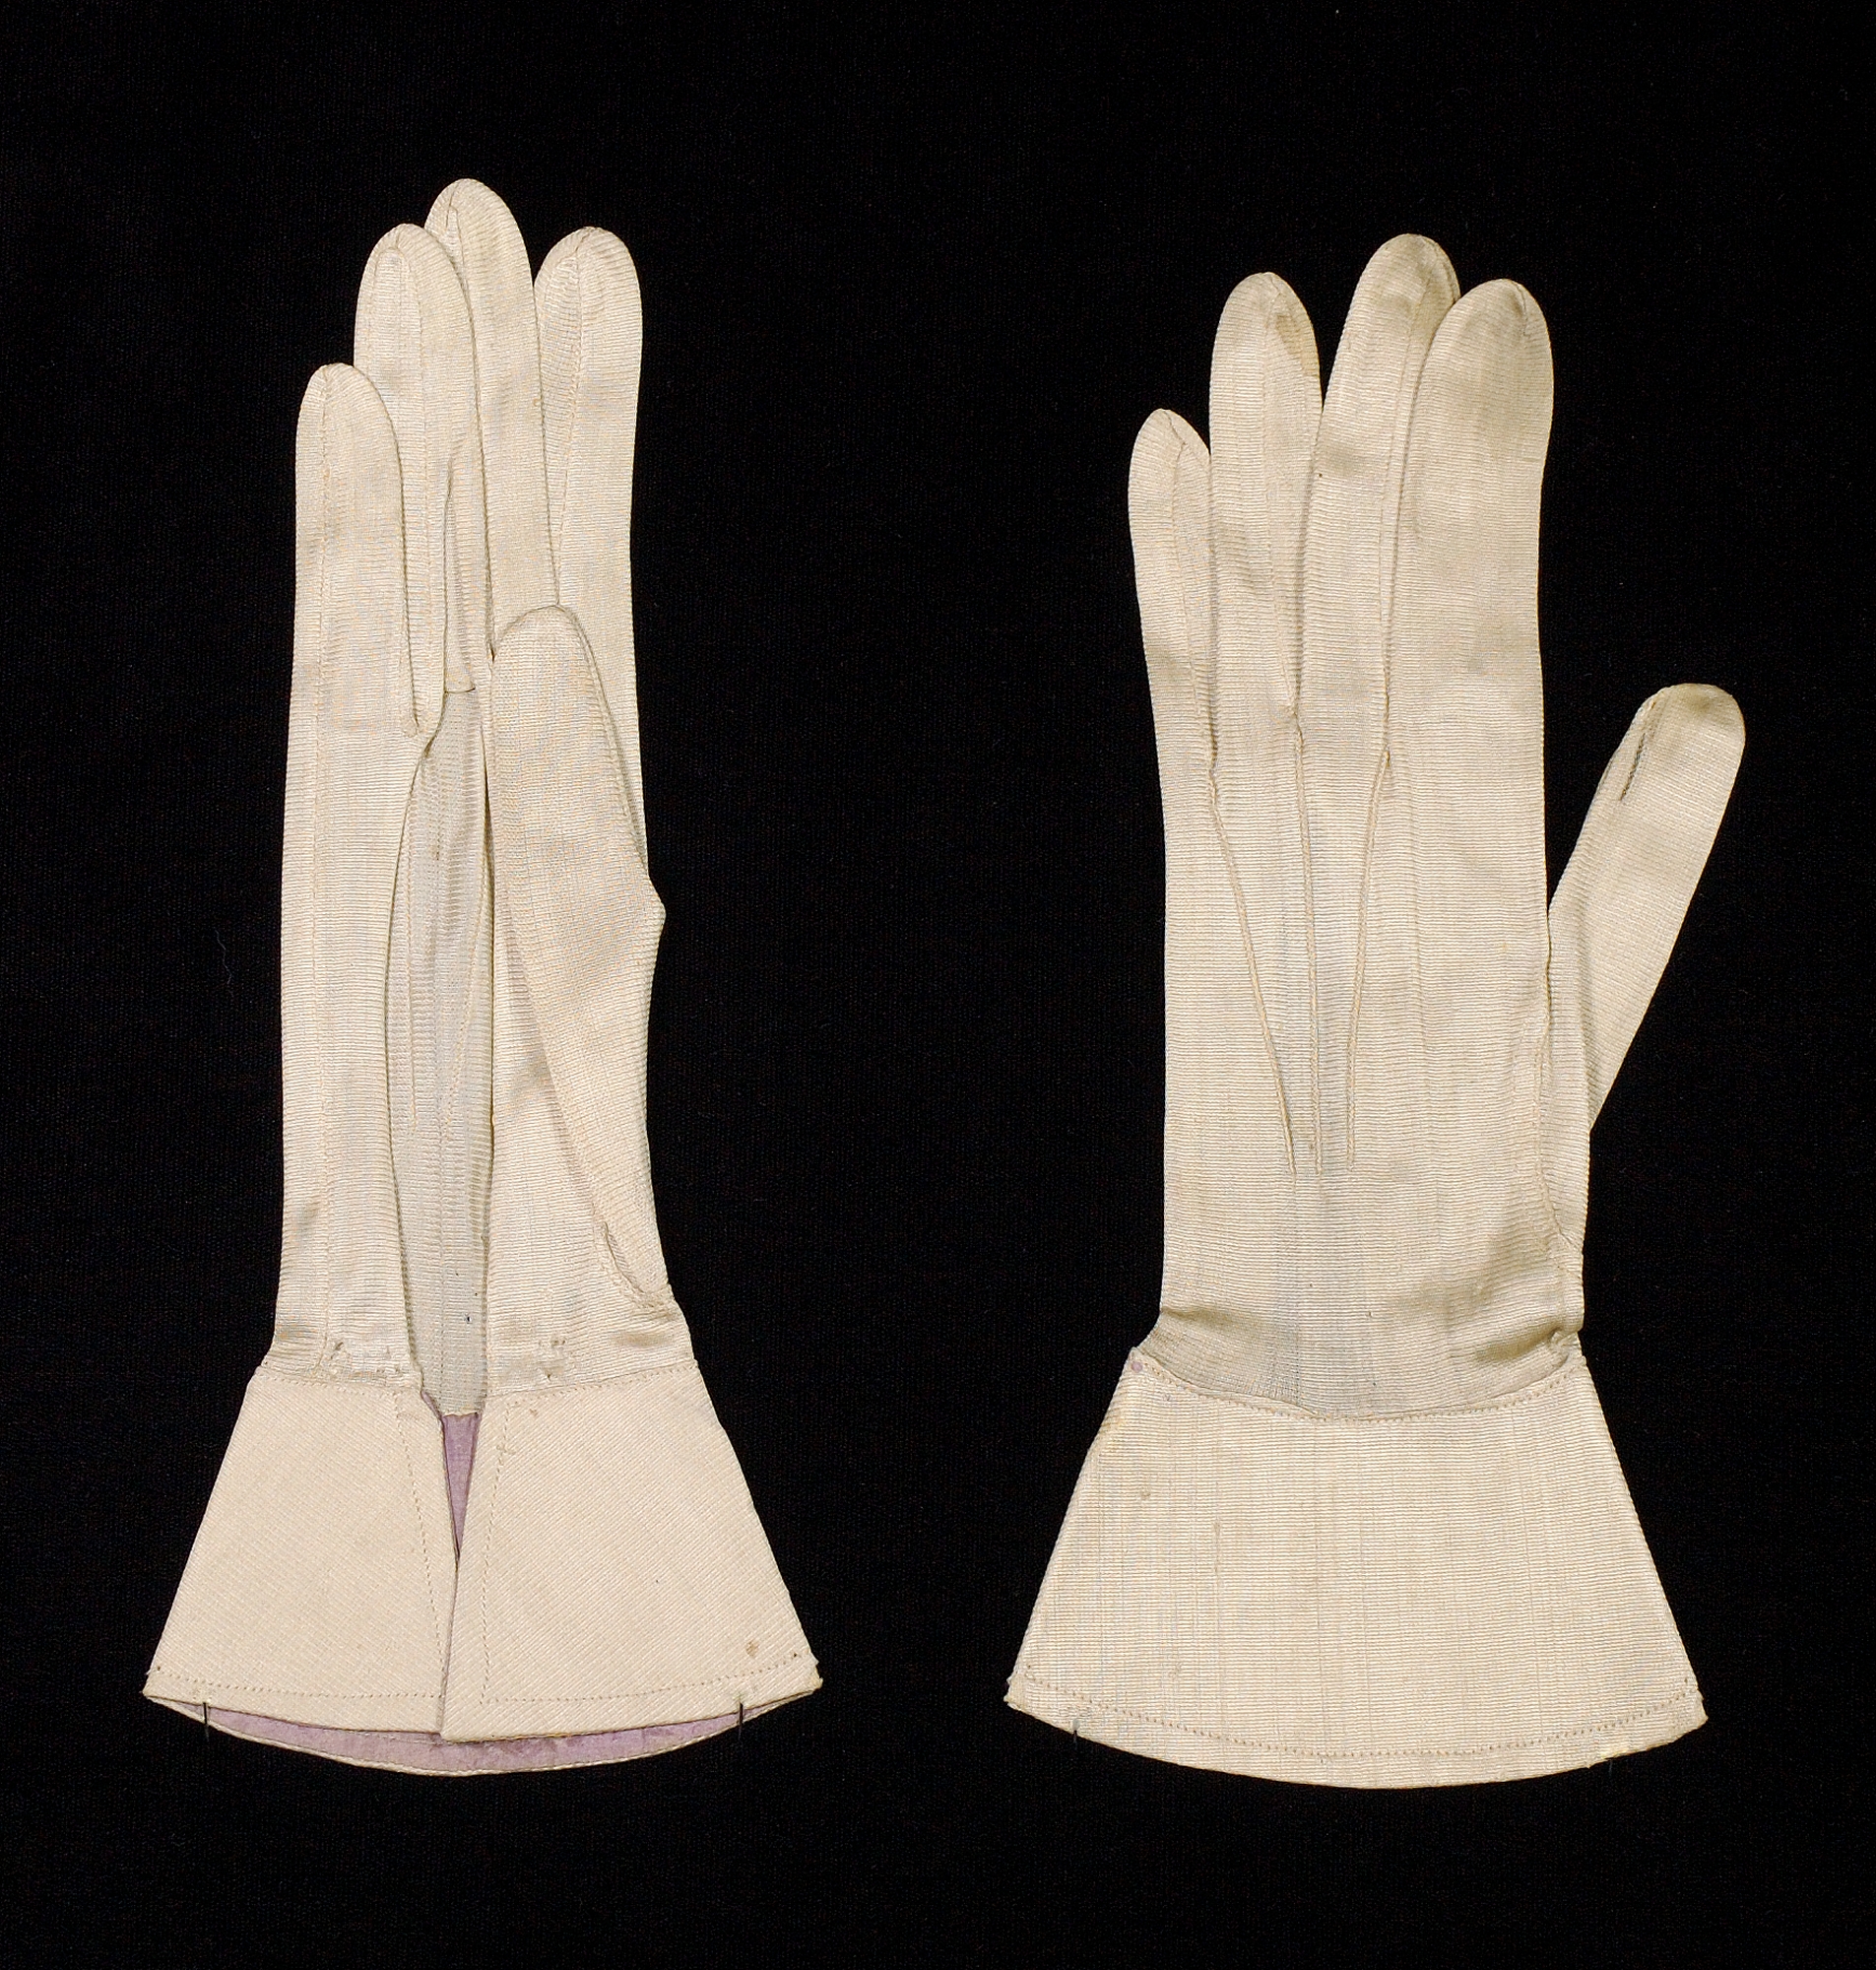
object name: glove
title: Gloves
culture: french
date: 1740-1760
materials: silk